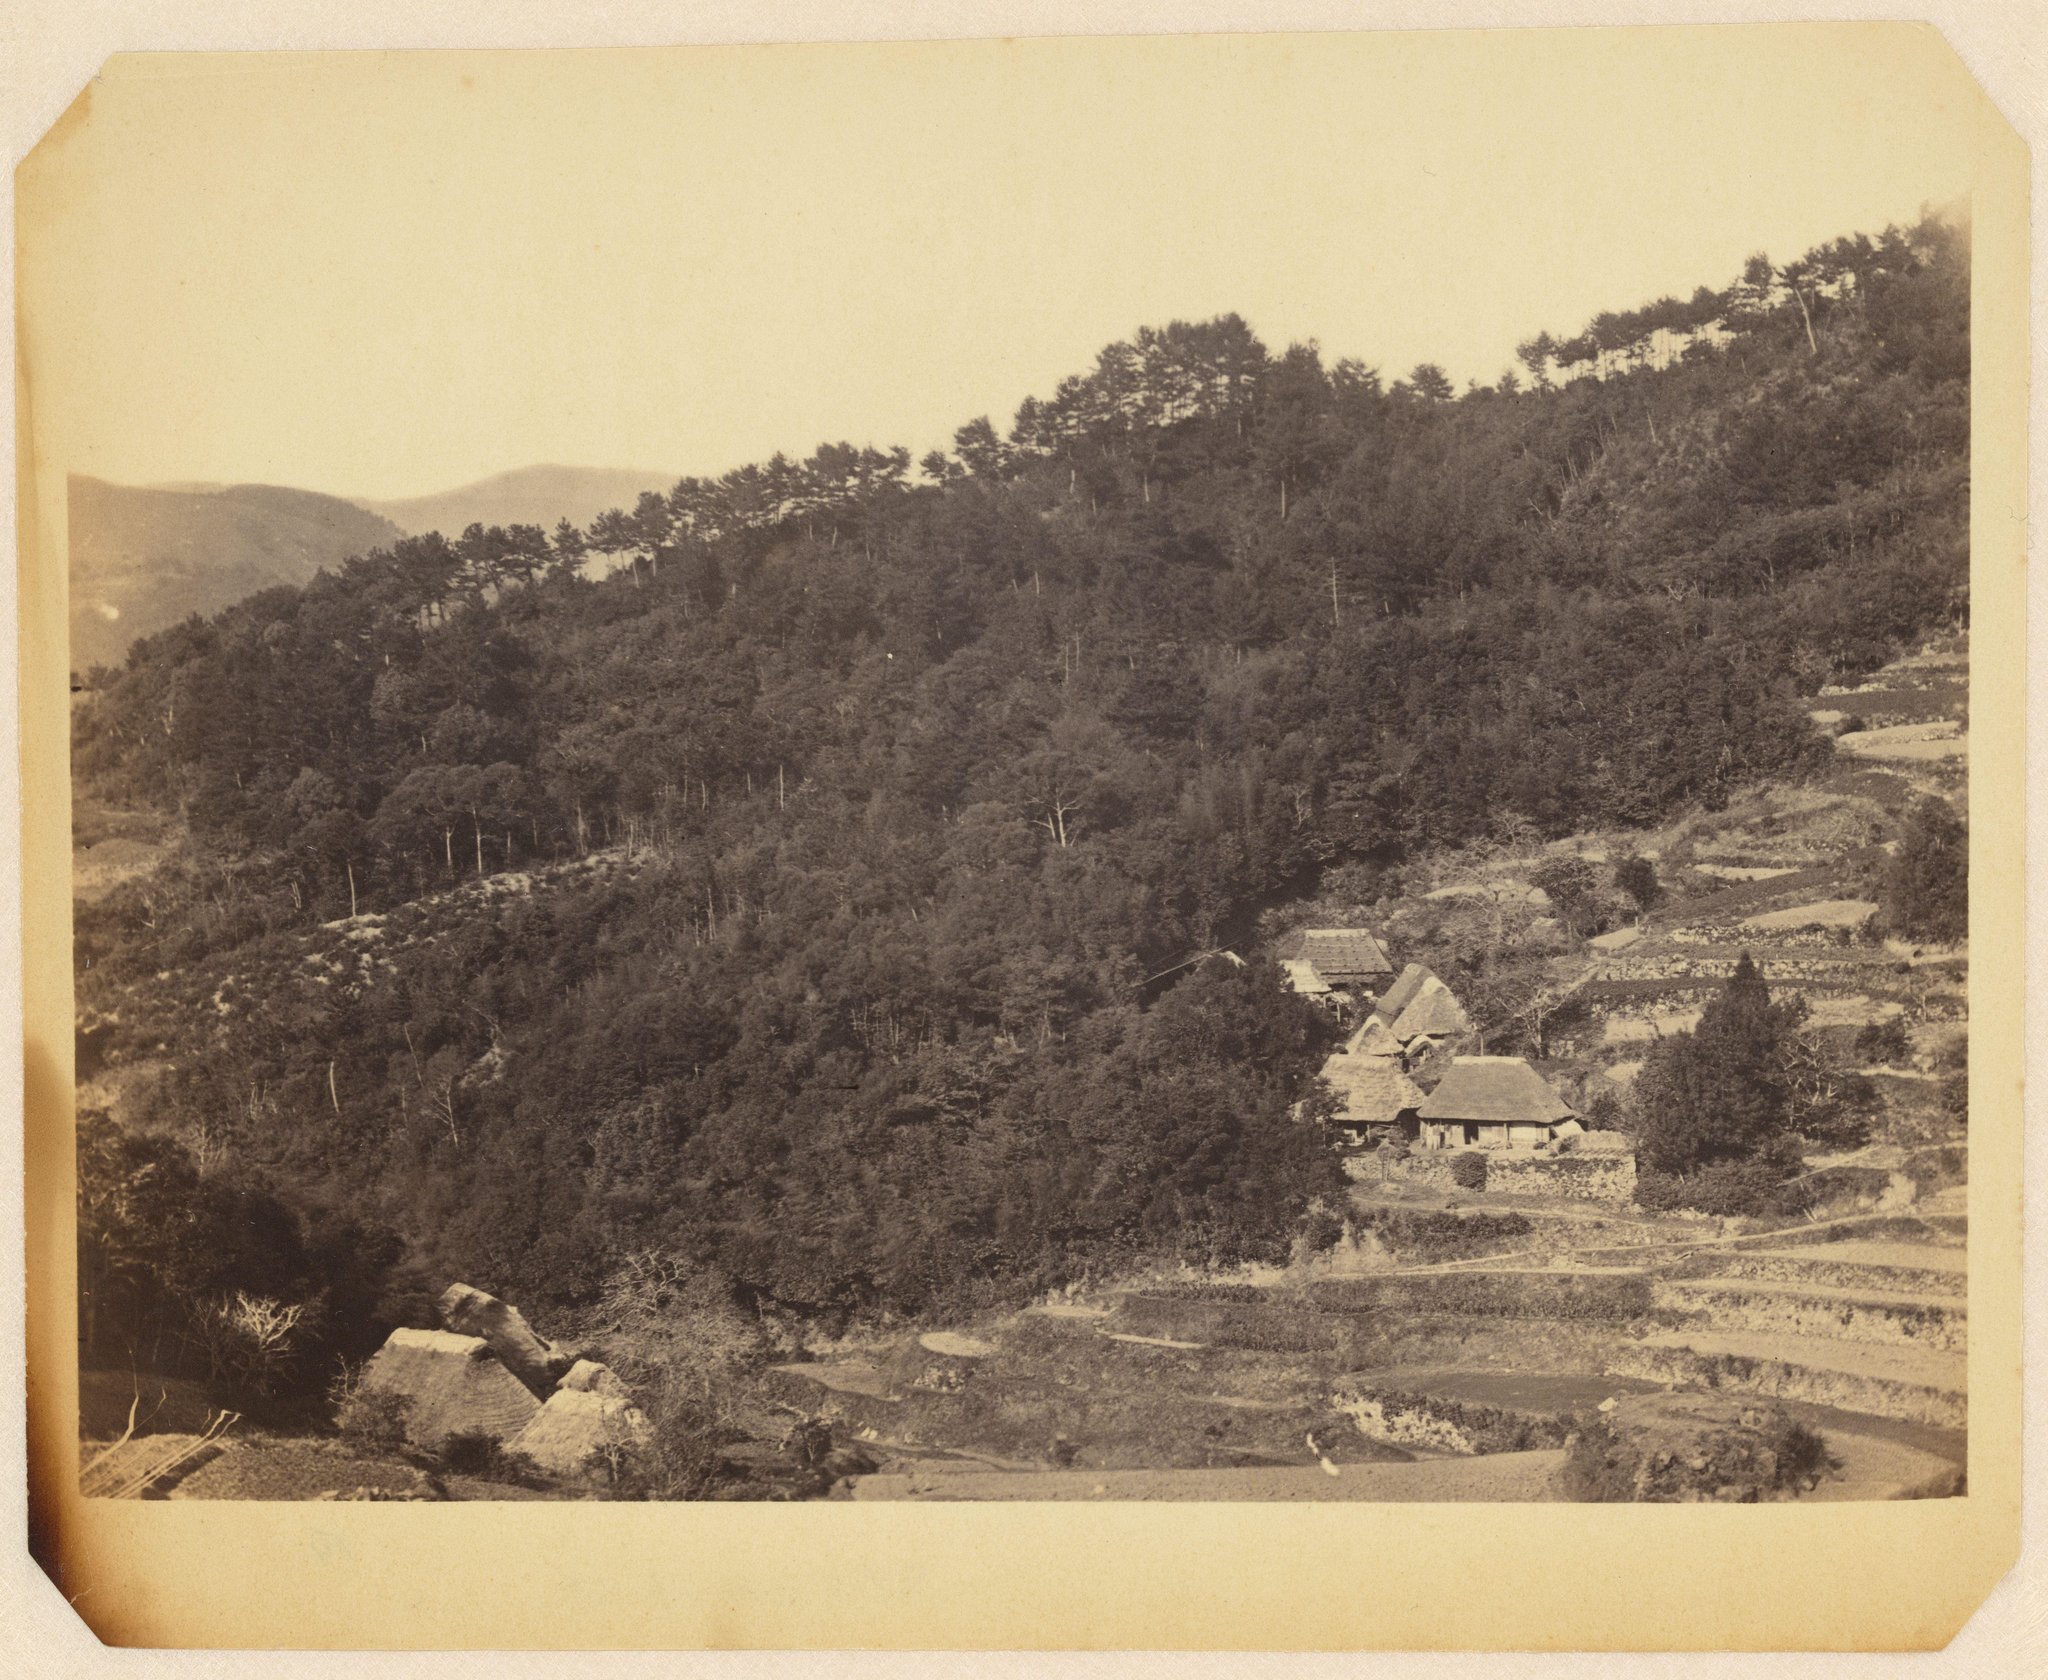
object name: photograph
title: Landscape near Nagasaki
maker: antoon bauduin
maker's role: amateurfotograaf, hoogleraar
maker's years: 1820-1885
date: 1862-1866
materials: paper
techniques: albumen print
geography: japan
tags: (high) hill, japan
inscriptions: number: ‘F4’, number: ‘B111’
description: Some of Bauduin’s landscape photographs are difficult or impossible to place. Nagasaki has grown vastly since he and Albert lived there. Much of what was still countryside back then – as in this scene of rice paddies and thatched houses – is all built-up now.